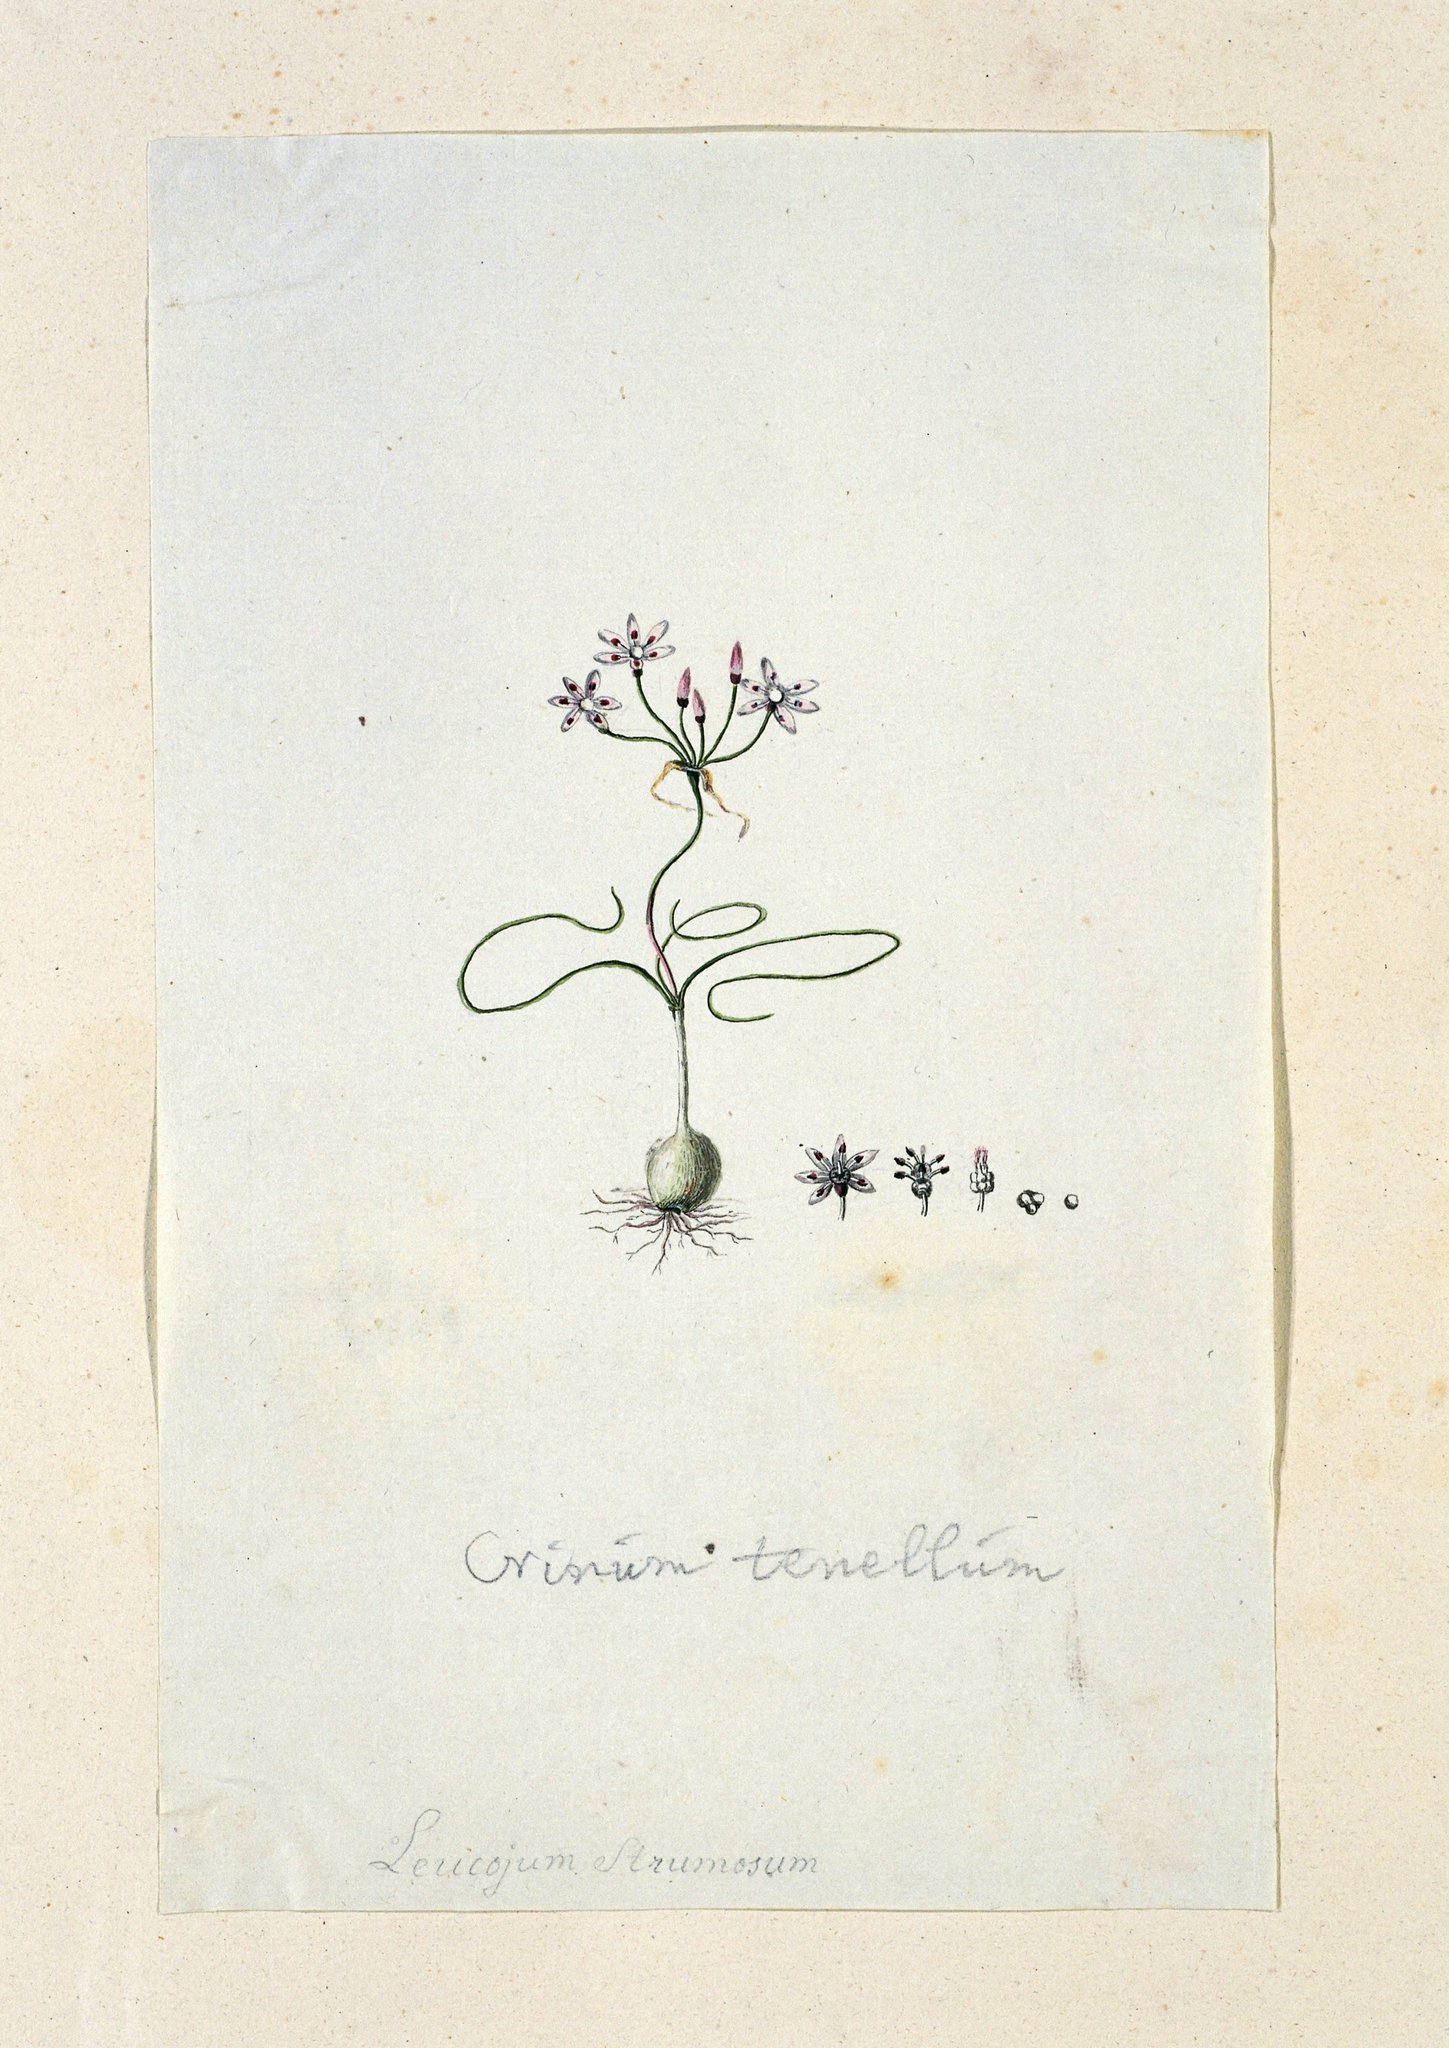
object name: drawing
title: Strumaria tenella (L.f. ) Snijman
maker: robert jacob gordon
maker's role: draughtsman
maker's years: 1743-1795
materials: chalk, paper, pencil, watercolor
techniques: brush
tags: plants; vegetation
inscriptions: annotation: ‘crinum tenellum; Leucojum Strumosum’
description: De tekening is gemaakt voor of tijdens een van Gordon's vier expedities door de Kaapprovincie, van oktober 1777 tot maart 1786. Sommige (soort)namen kunnen zijn gewijzigd, gezien reorganisatie in plantentaxonomie gedurende de afgelopen jaren.